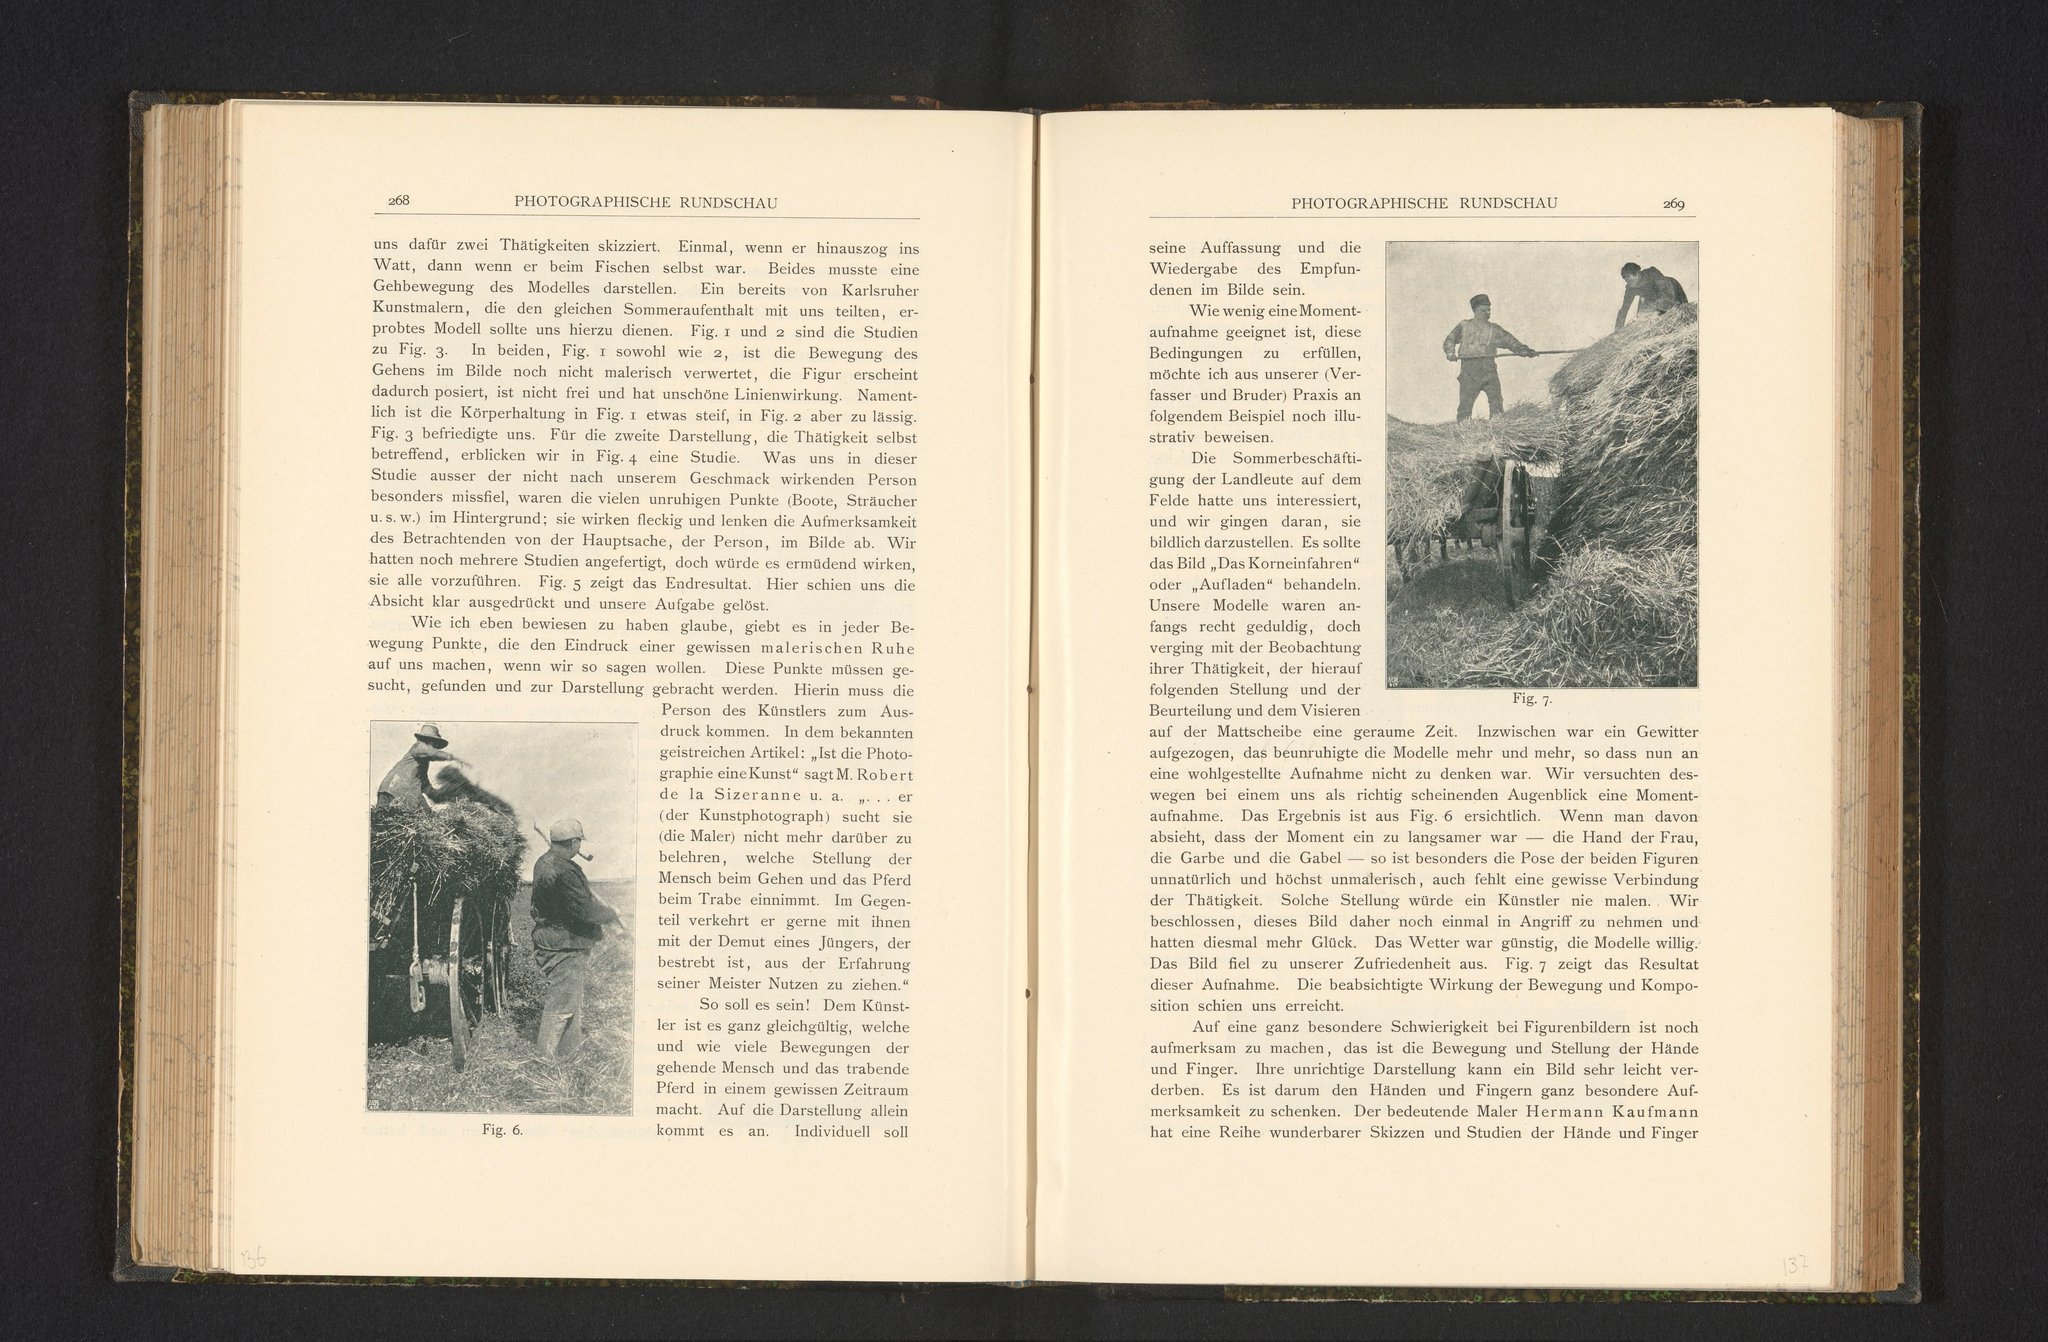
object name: photomechanical print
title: Gezicht op twee boeren die hooi op een kar verzamelen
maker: Anonymous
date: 1893-1898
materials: paper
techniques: autotype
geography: berlin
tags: agricultural products and by-products: hay, farmers, hay-wagon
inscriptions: monogram: ‘MR/ &Co’